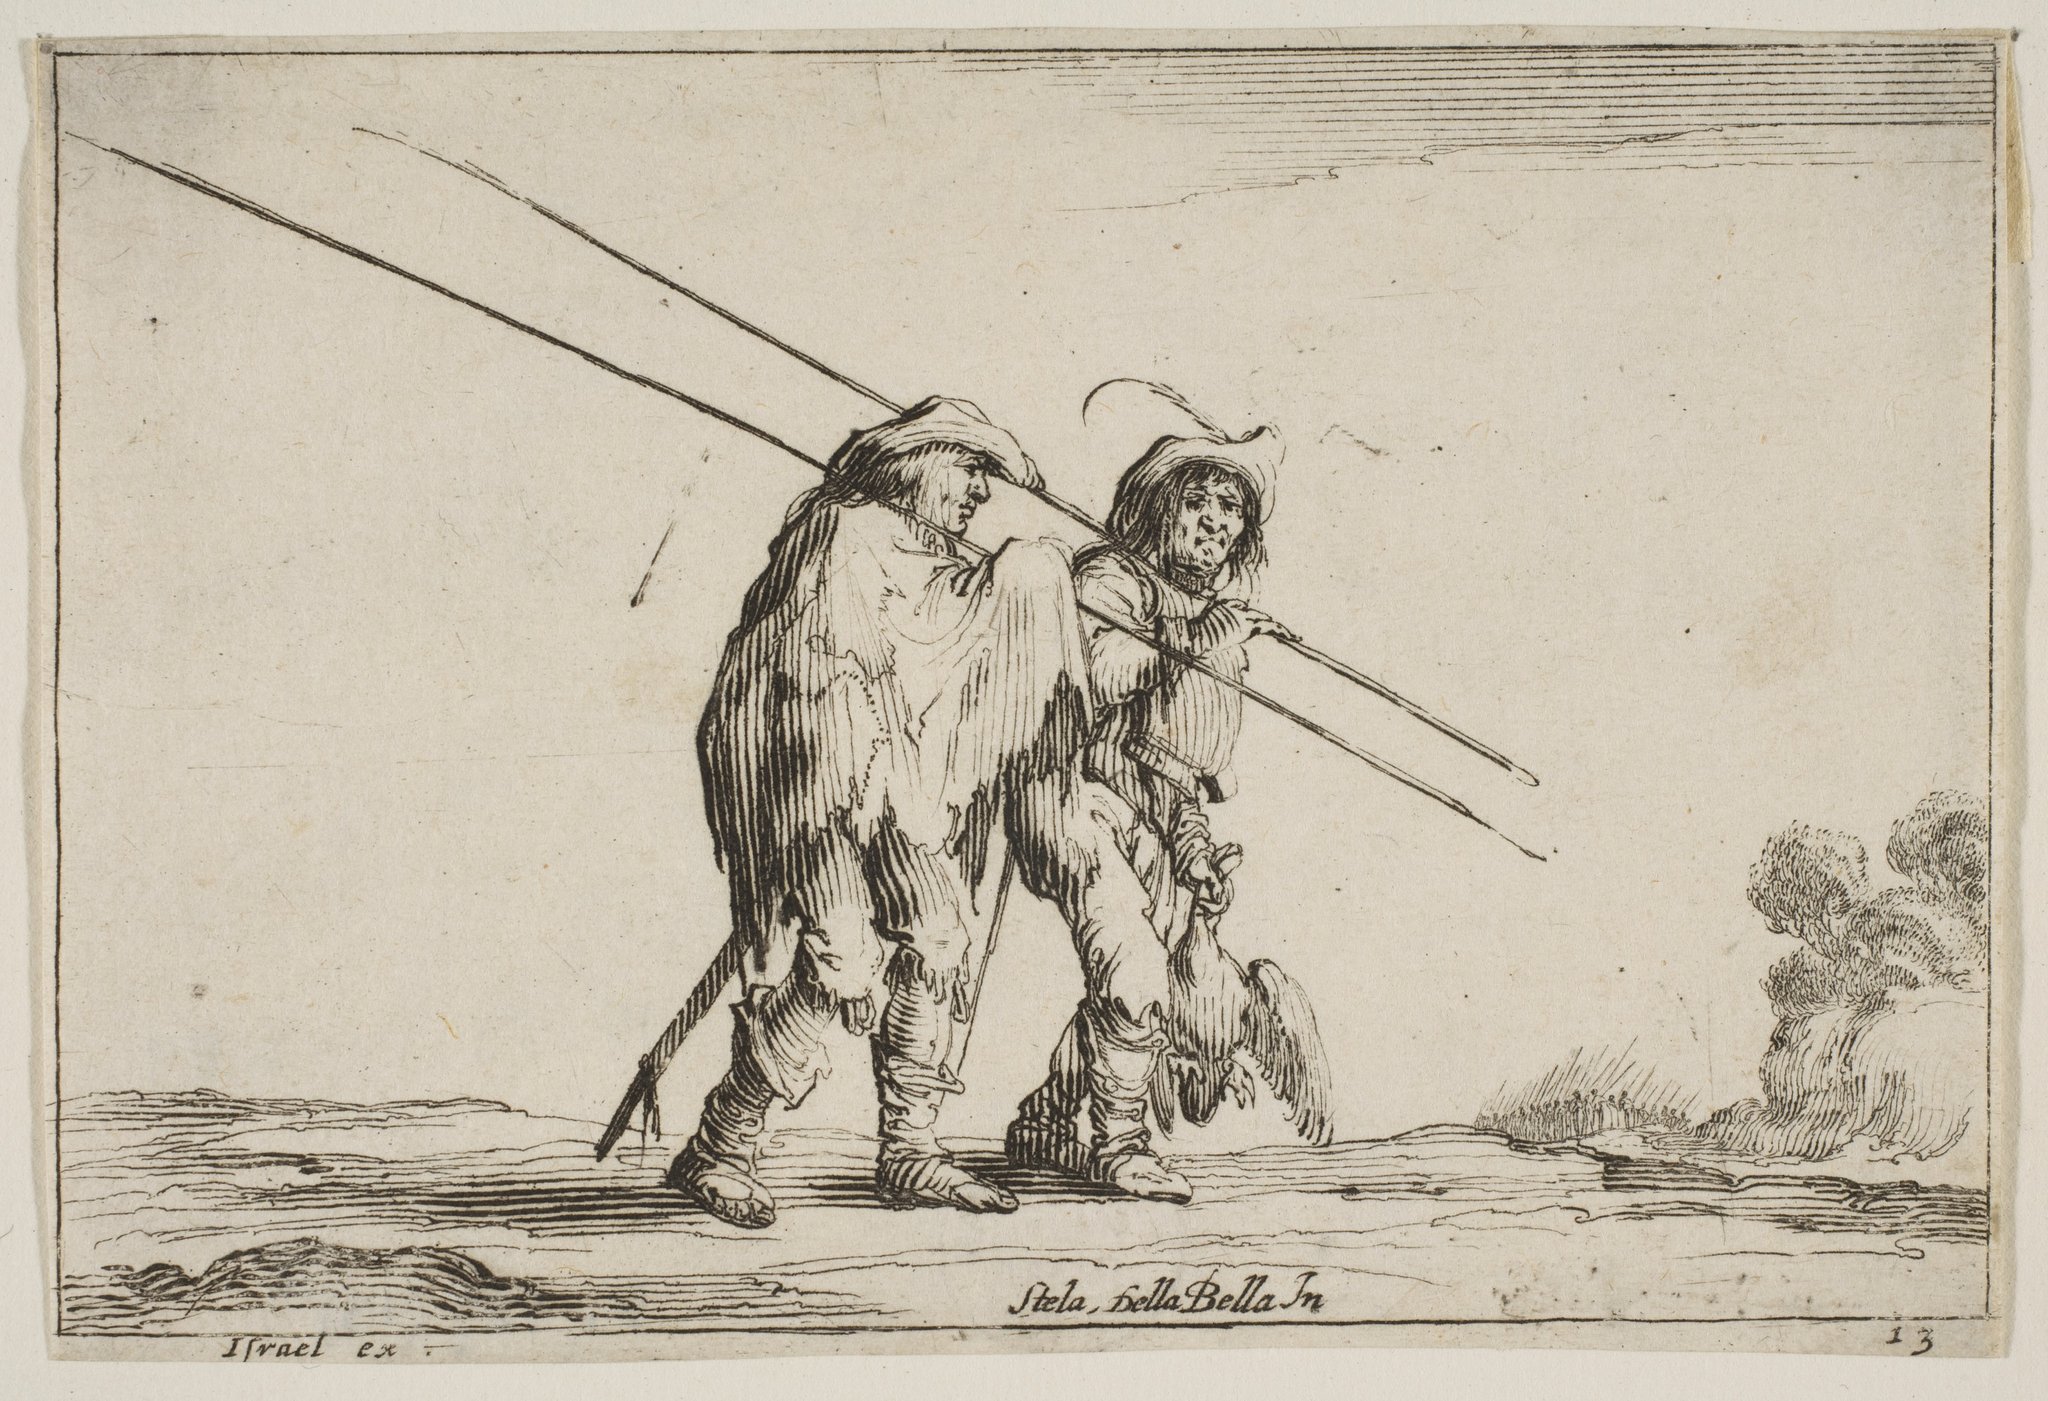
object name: print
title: Two pikemen walking towards the right, each with their pikes in their right hands, plate 13 from "Various Figures" (Agréable diversité de figures)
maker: stefano della bella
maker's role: artist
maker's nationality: italian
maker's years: 1610-1664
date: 1642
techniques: engraving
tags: soldiers,weapons,men